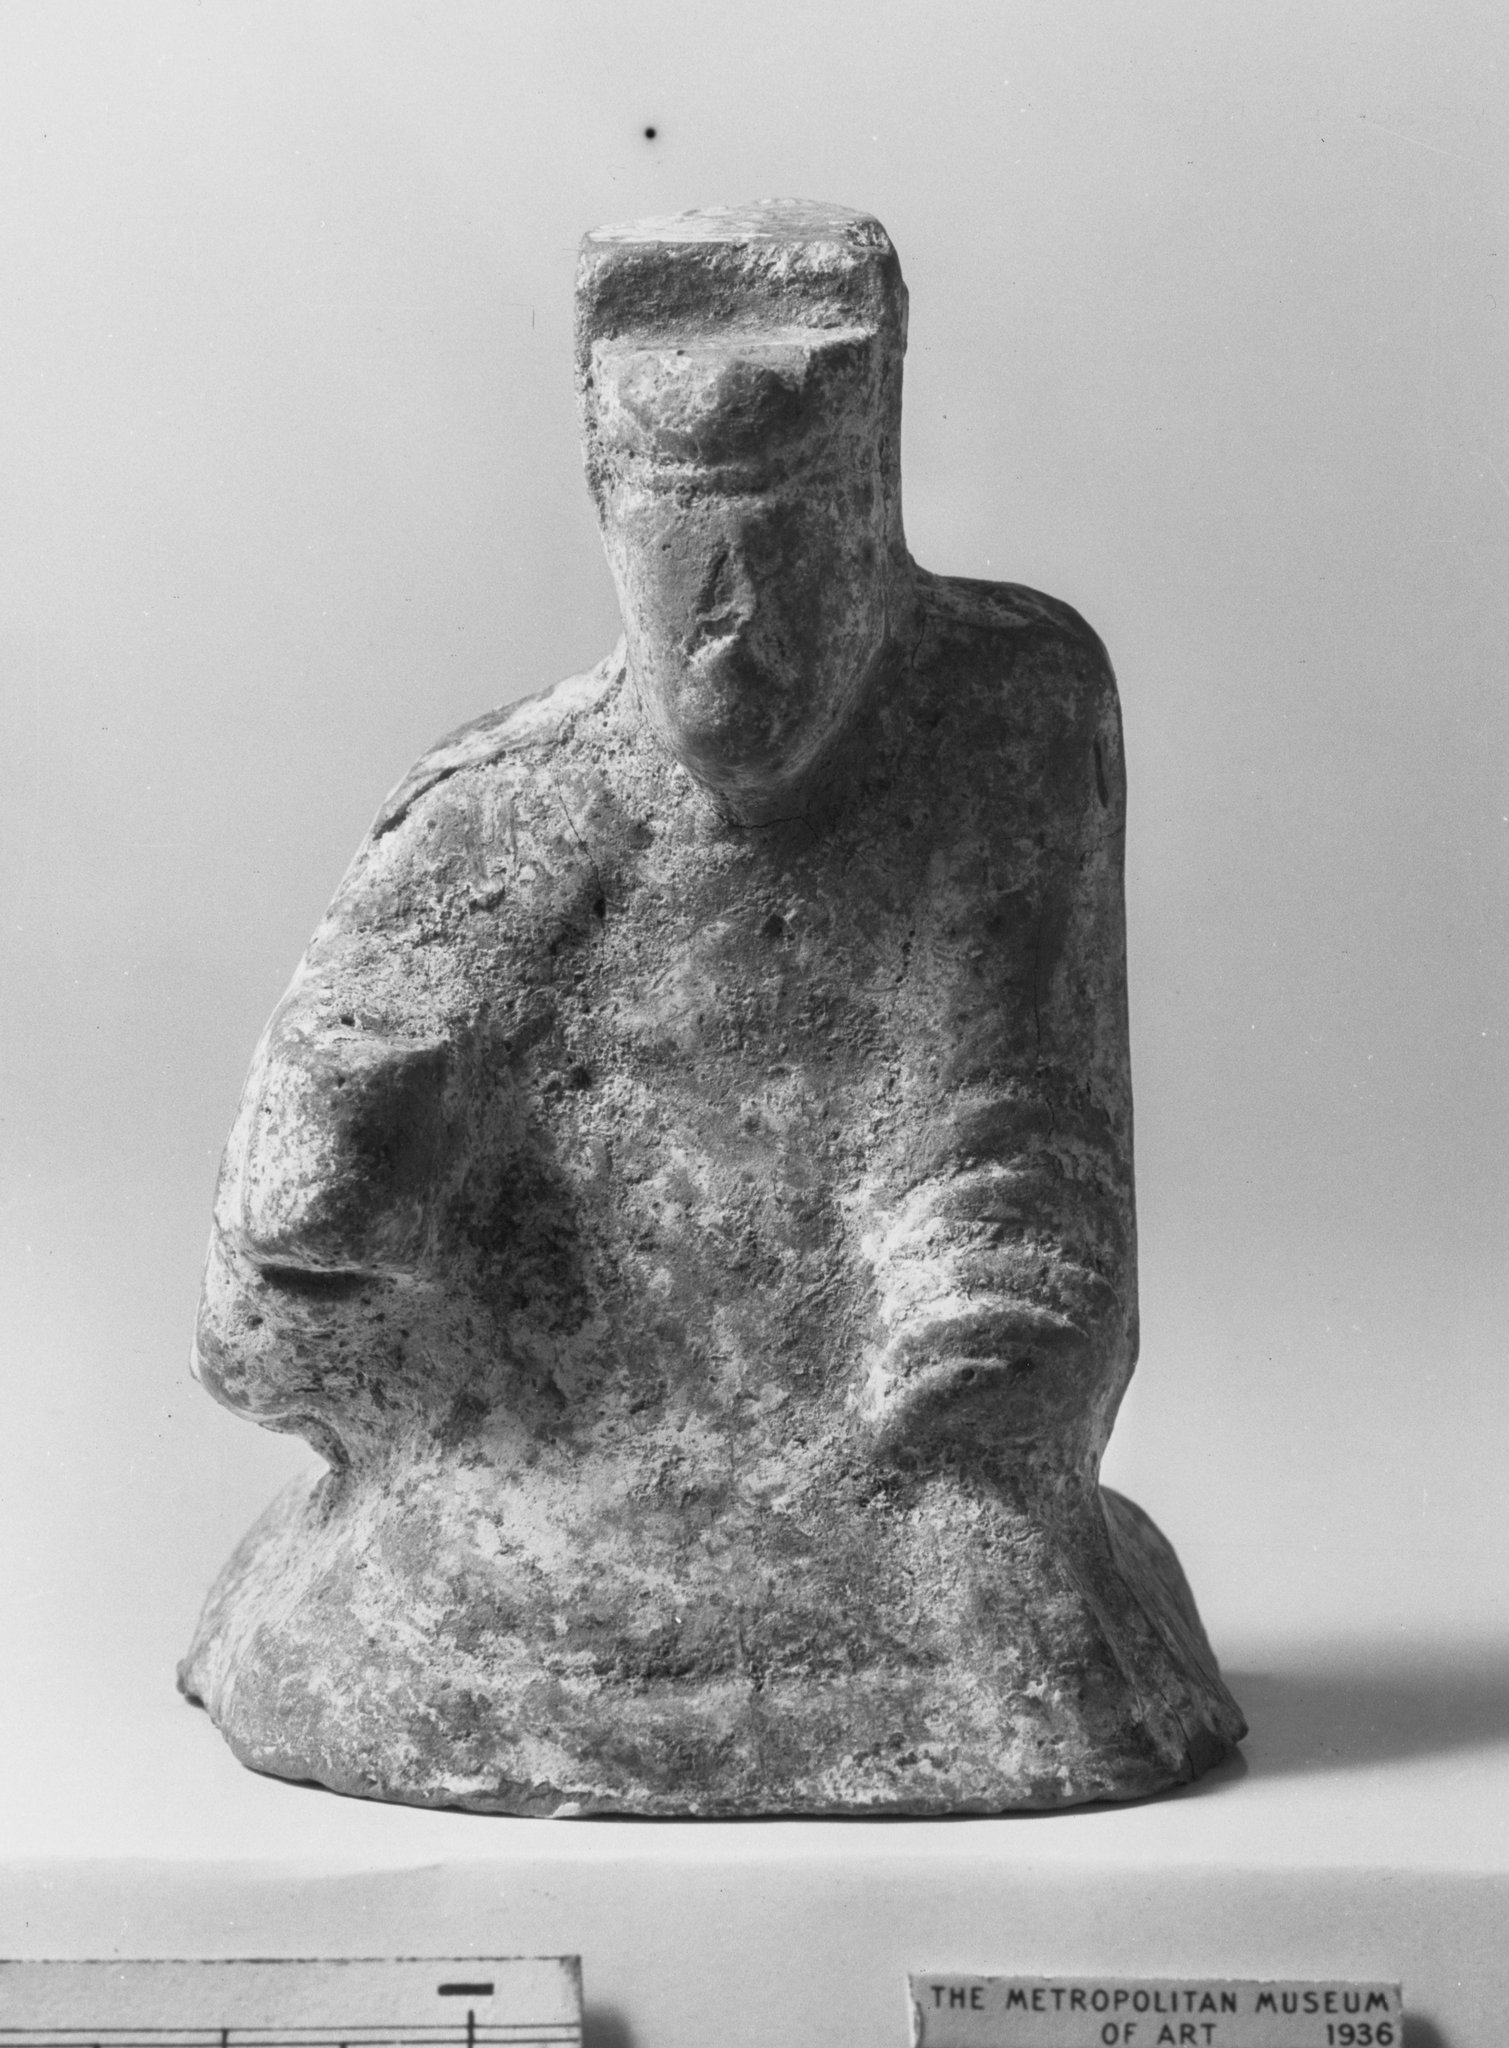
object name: figure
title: Figure of Entertainer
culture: chinese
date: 206 BCE-220 CE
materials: paint, pottery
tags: men